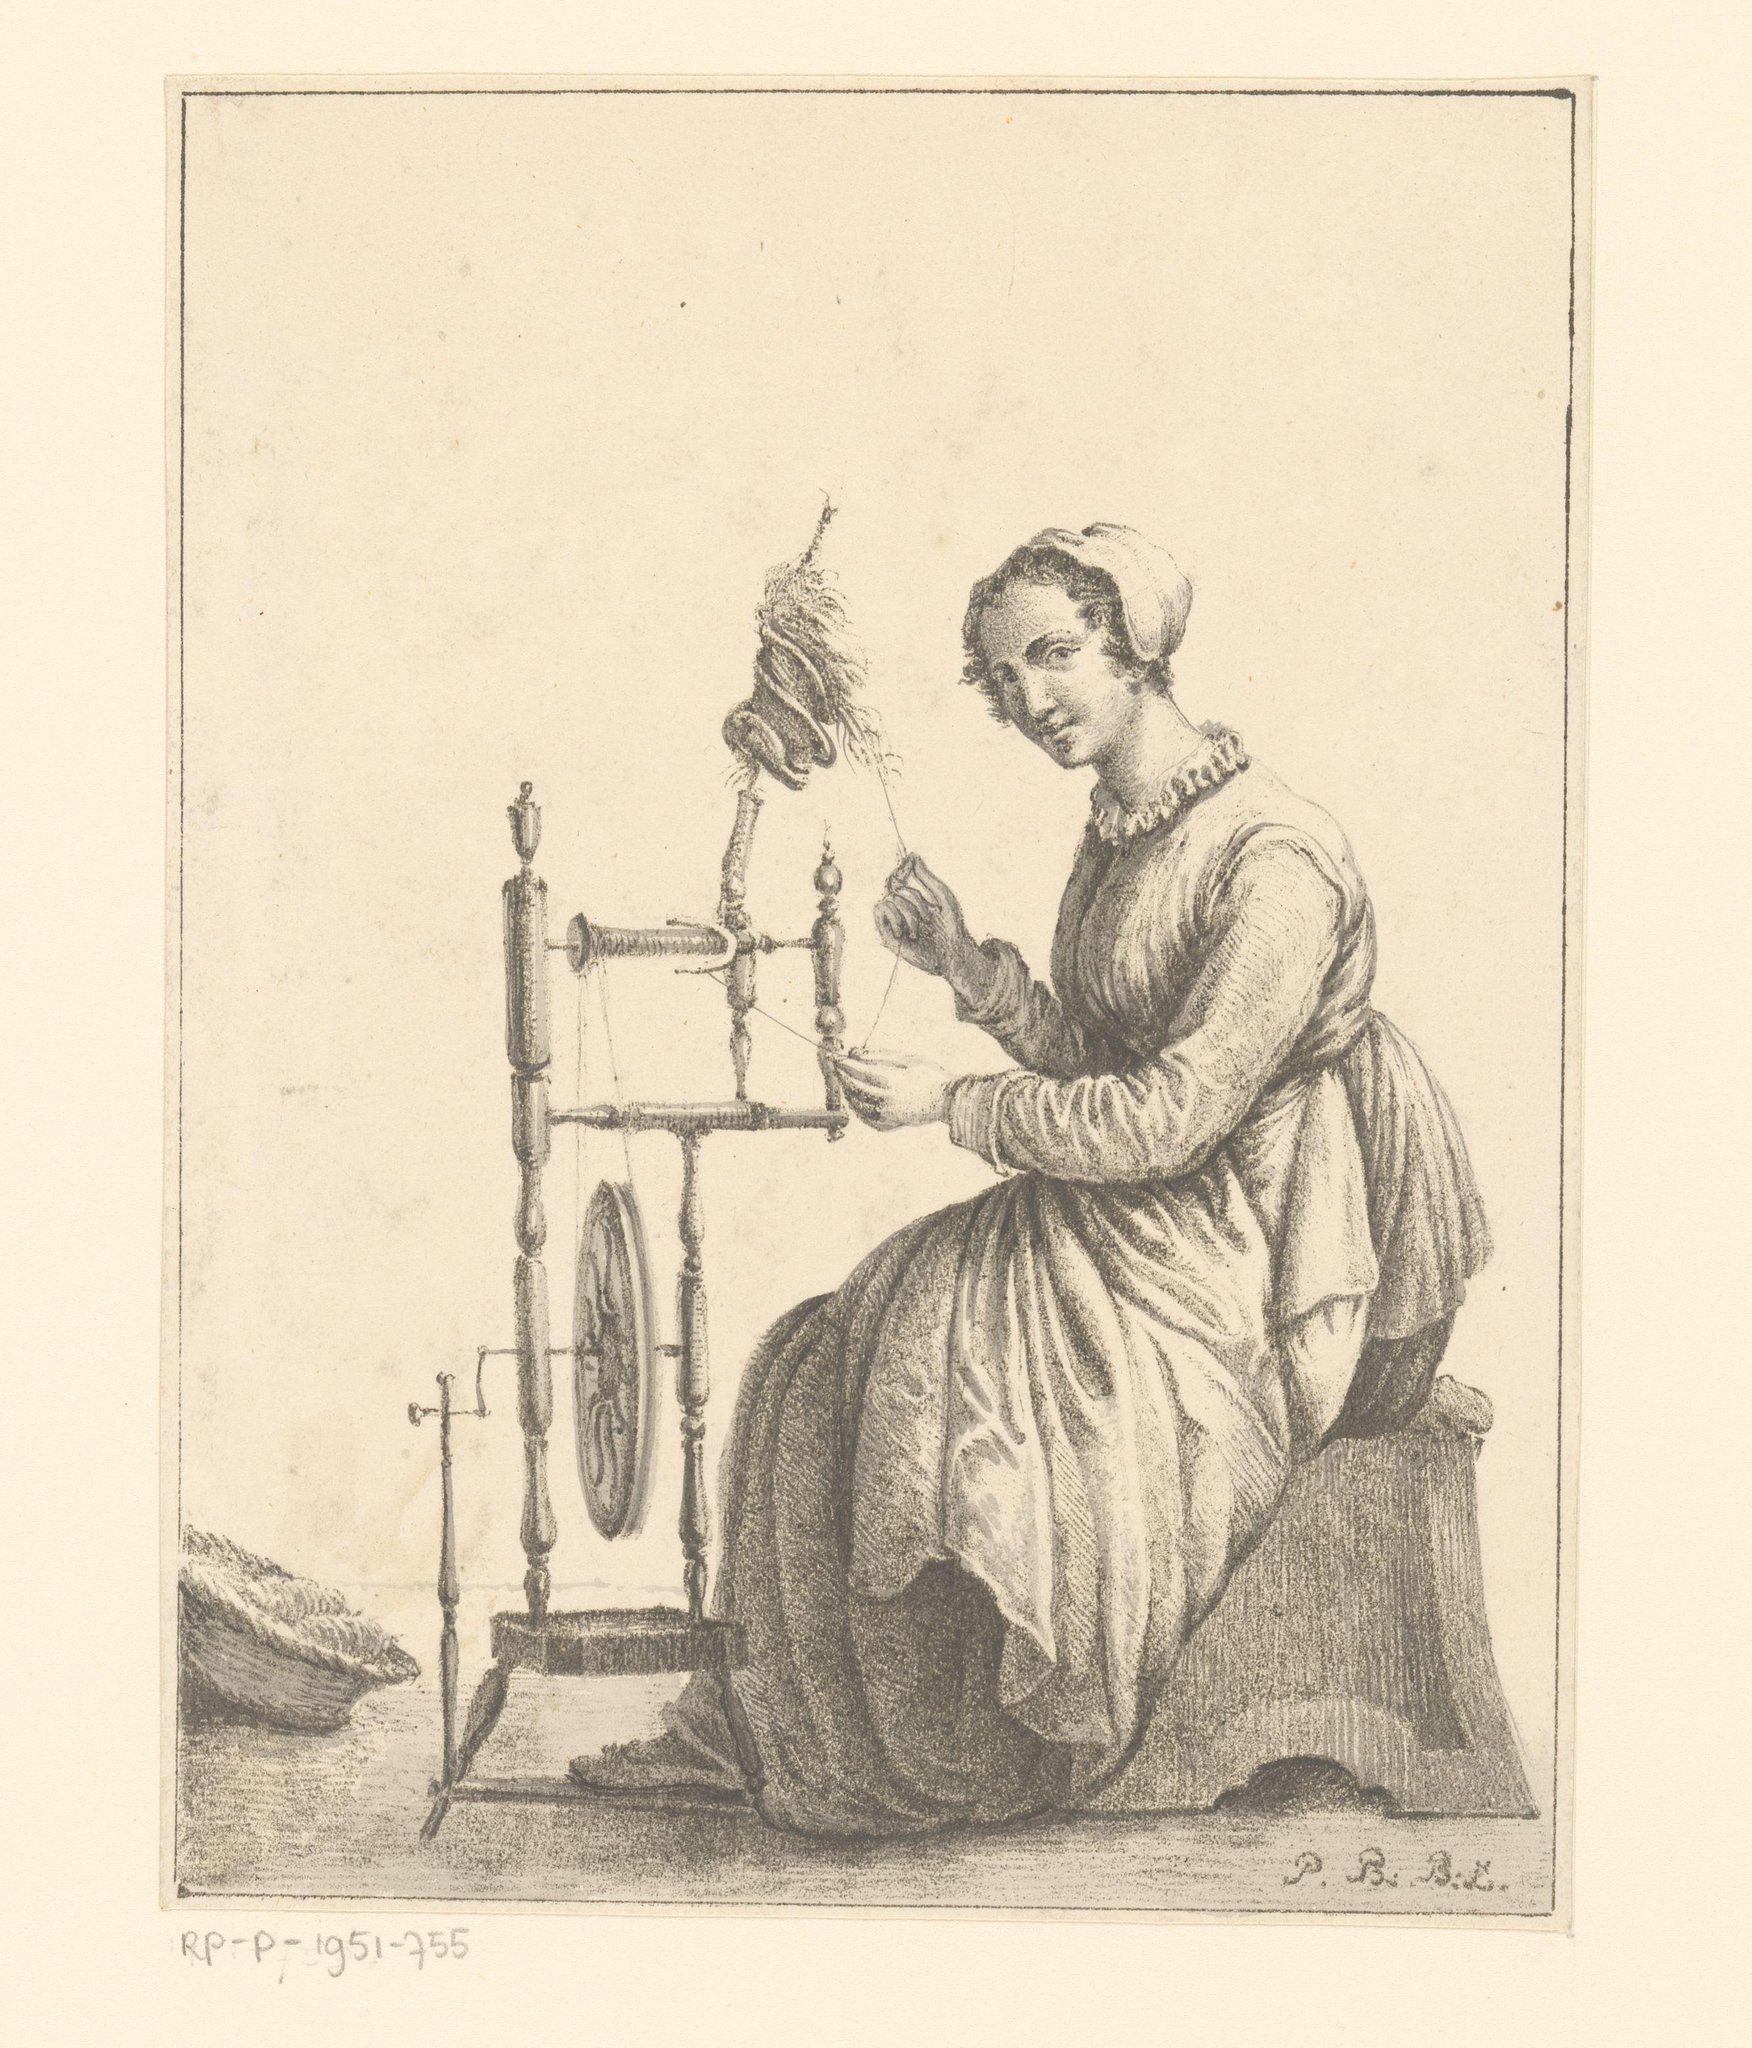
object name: print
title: Zittende vrouw bij spinnewiel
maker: pieter bartholomeusz. barbiers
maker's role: draughtsman, print maker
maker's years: 1772-1837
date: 1809-1837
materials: ink, paper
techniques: brush, lithograph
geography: haarlem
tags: spinning-wheel, spinning (manufacture of yarn)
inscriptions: collector's mark: Lugt 2228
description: Een vrouw spint garen aan een spinnewiel en kijkt op. Op de grond voor haar staat een mand.